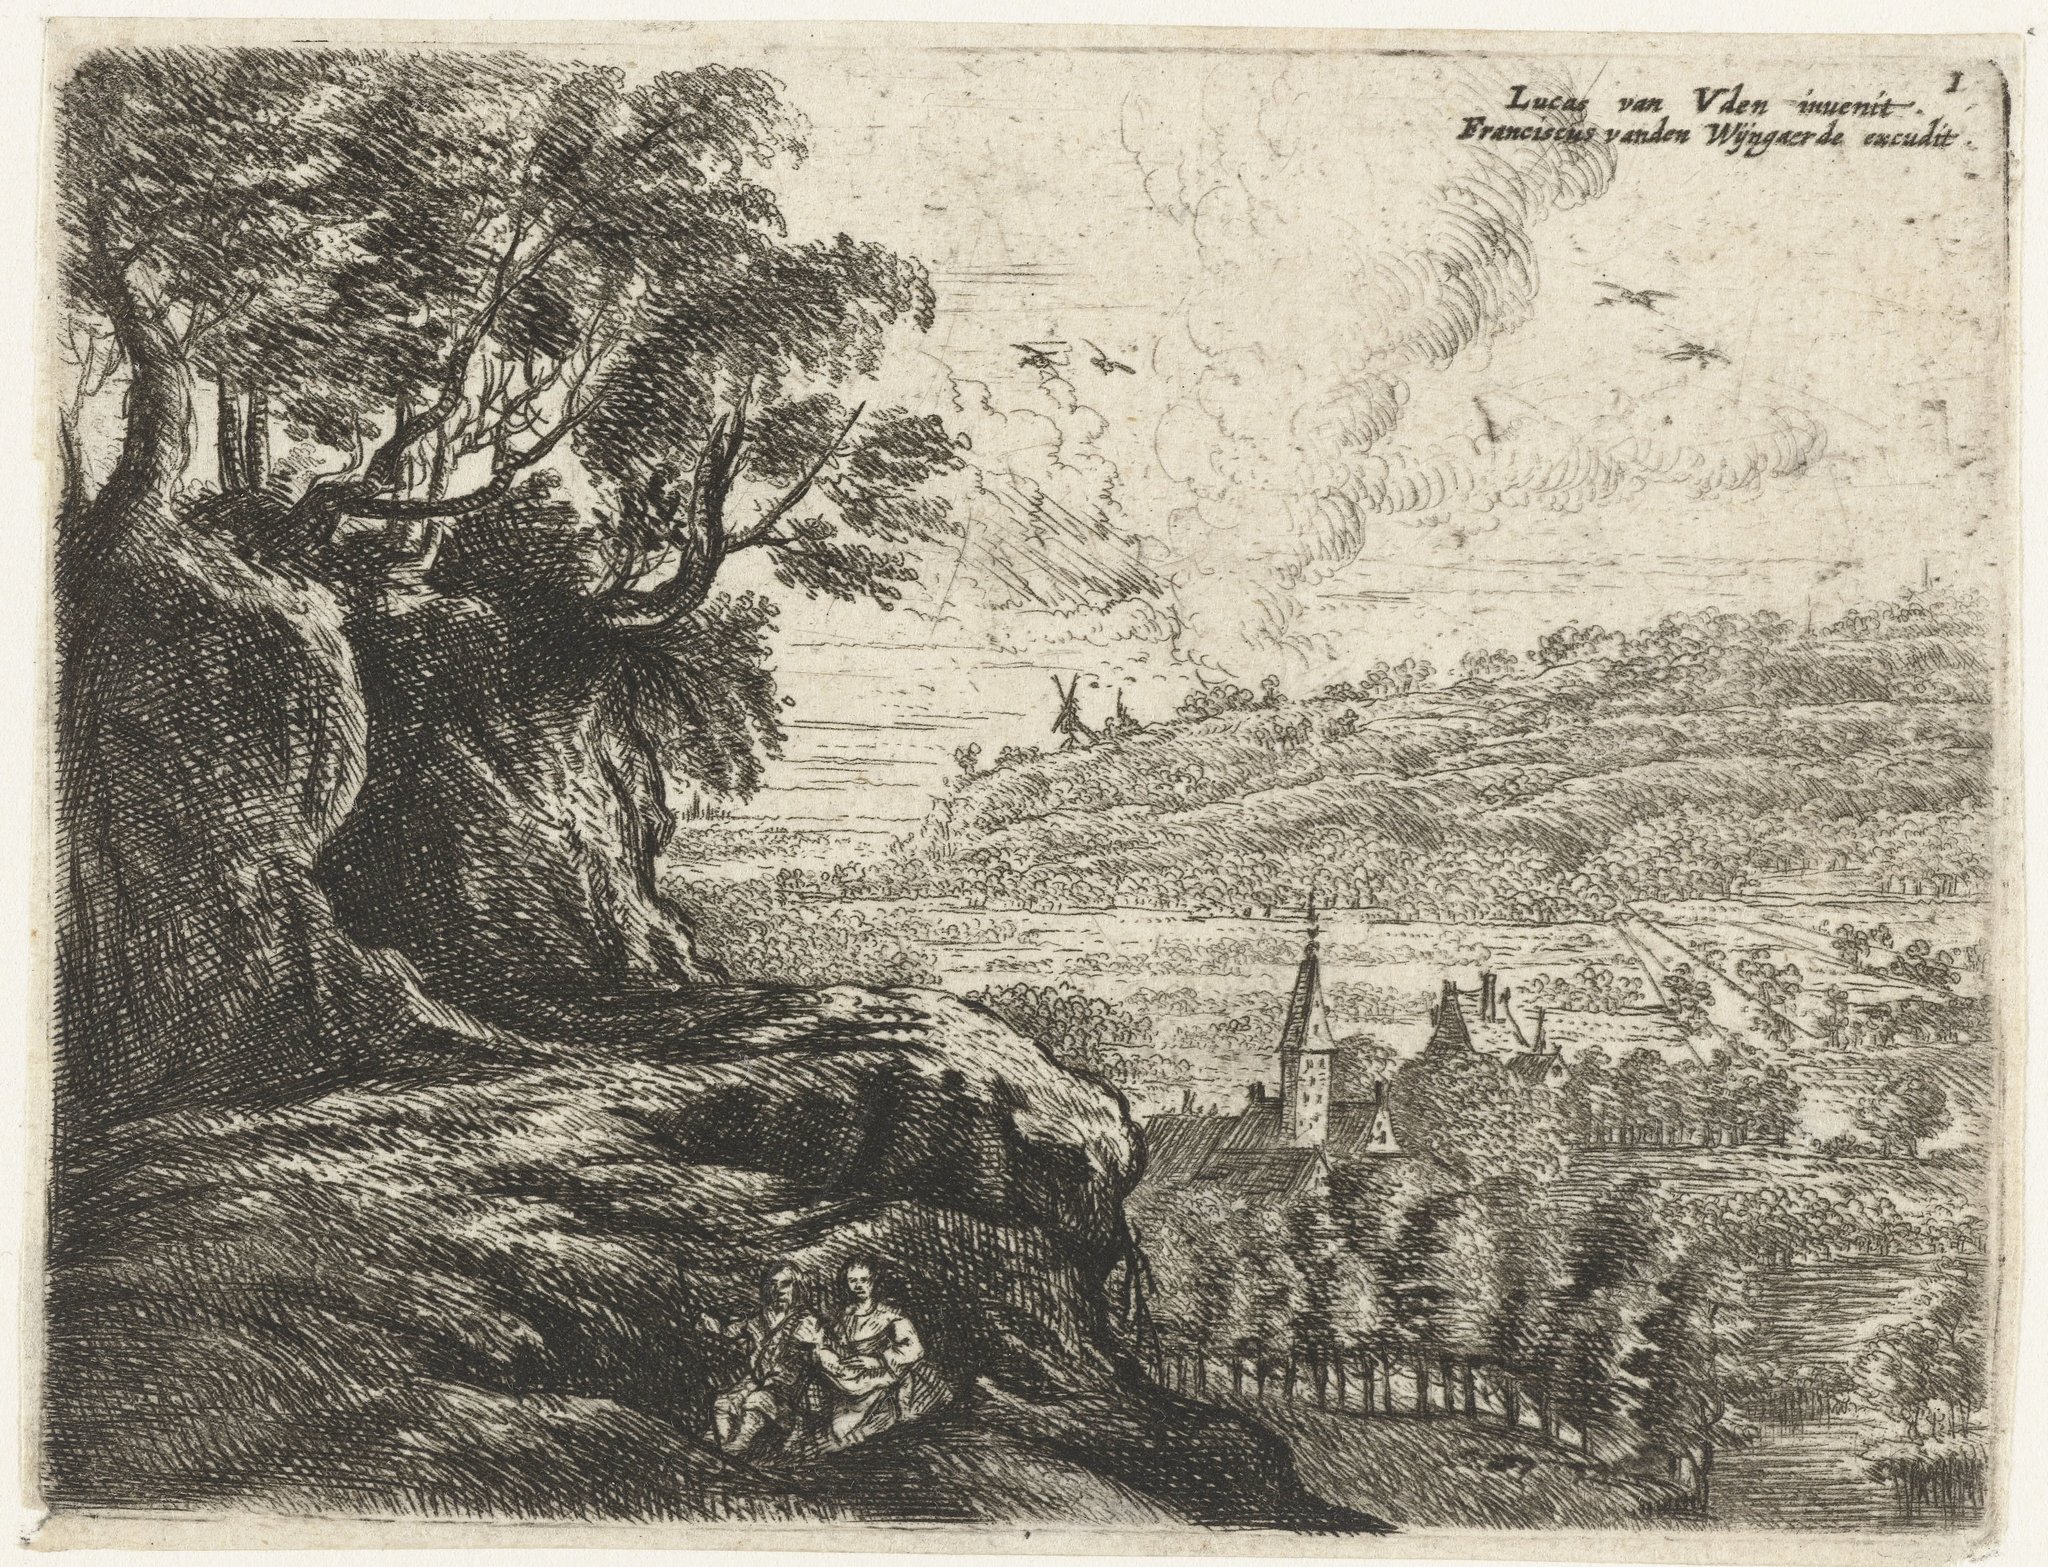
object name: print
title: Landschap met een man, vrouw en kind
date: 1637-1679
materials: paper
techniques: etching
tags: the (nude) human figure; 'corpo humano' (ripa) (+ three persons), landscape with tower or castle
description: Eerste uit een serie van acht. Heuvelig landschap met op de voorgrond een man en vrouw met kind.